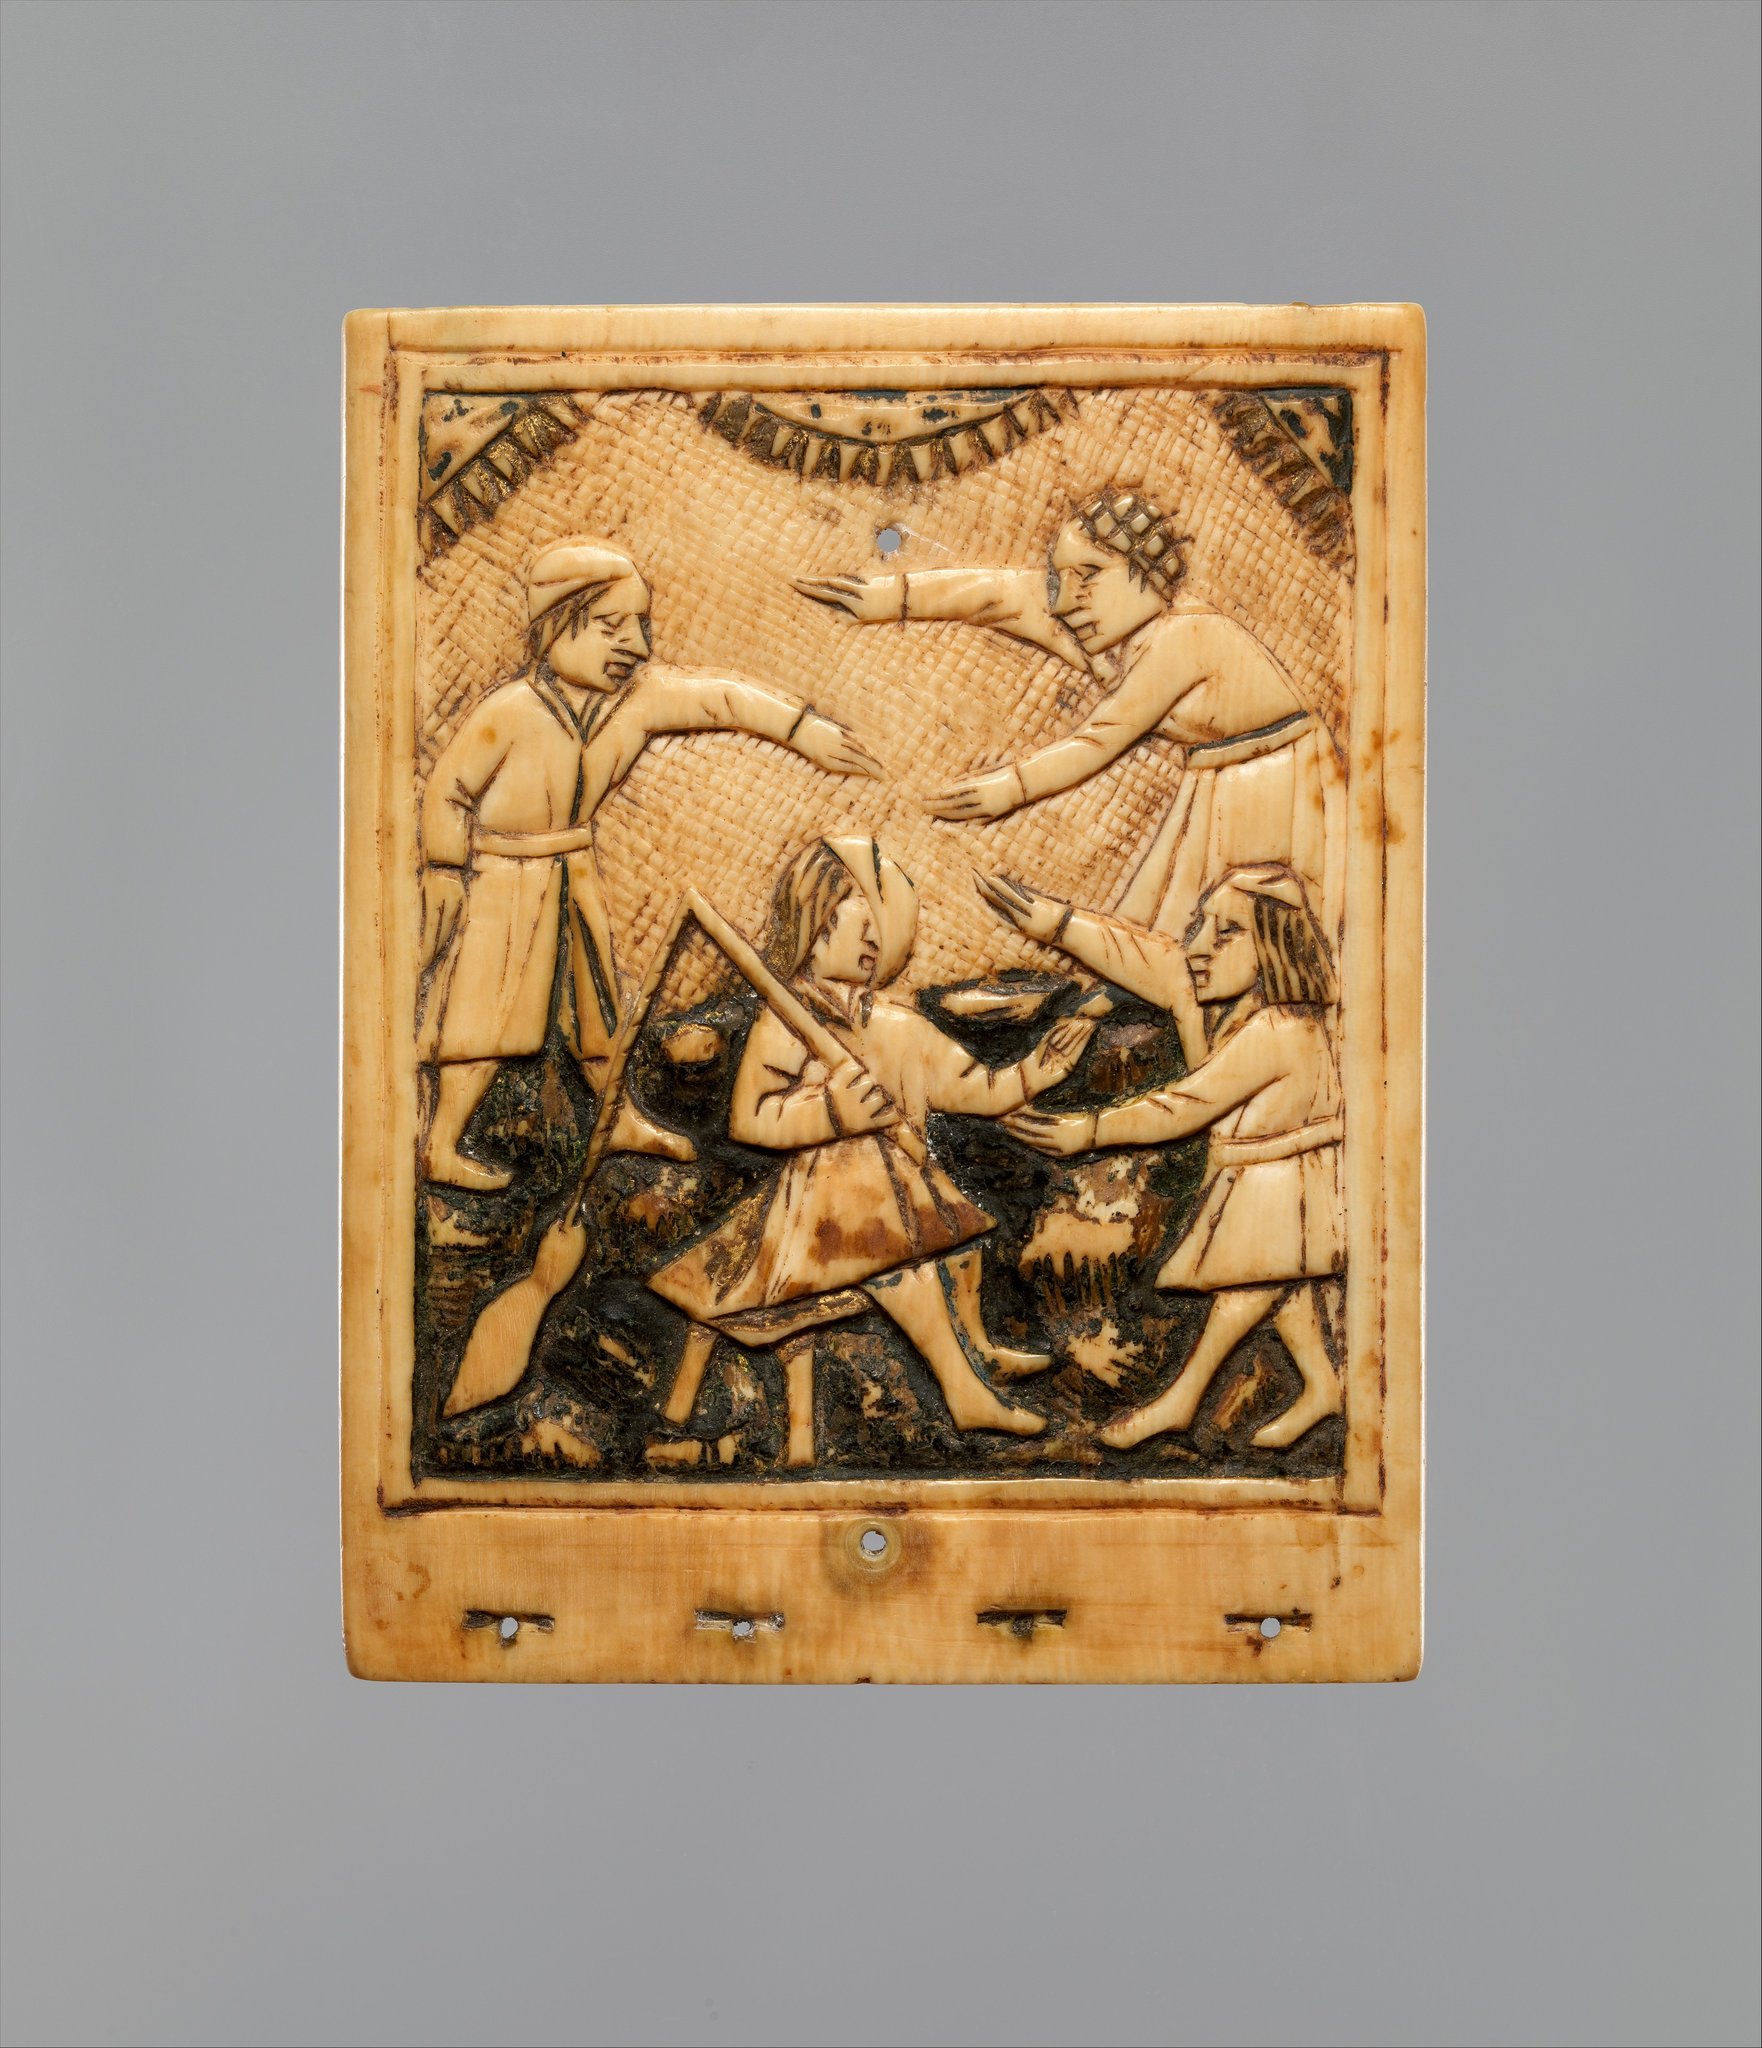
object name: sundial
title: Upper Leaf of Sundial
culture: german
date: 1500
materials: ivory, paint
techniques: gilding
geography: germany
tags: boys,playing,games